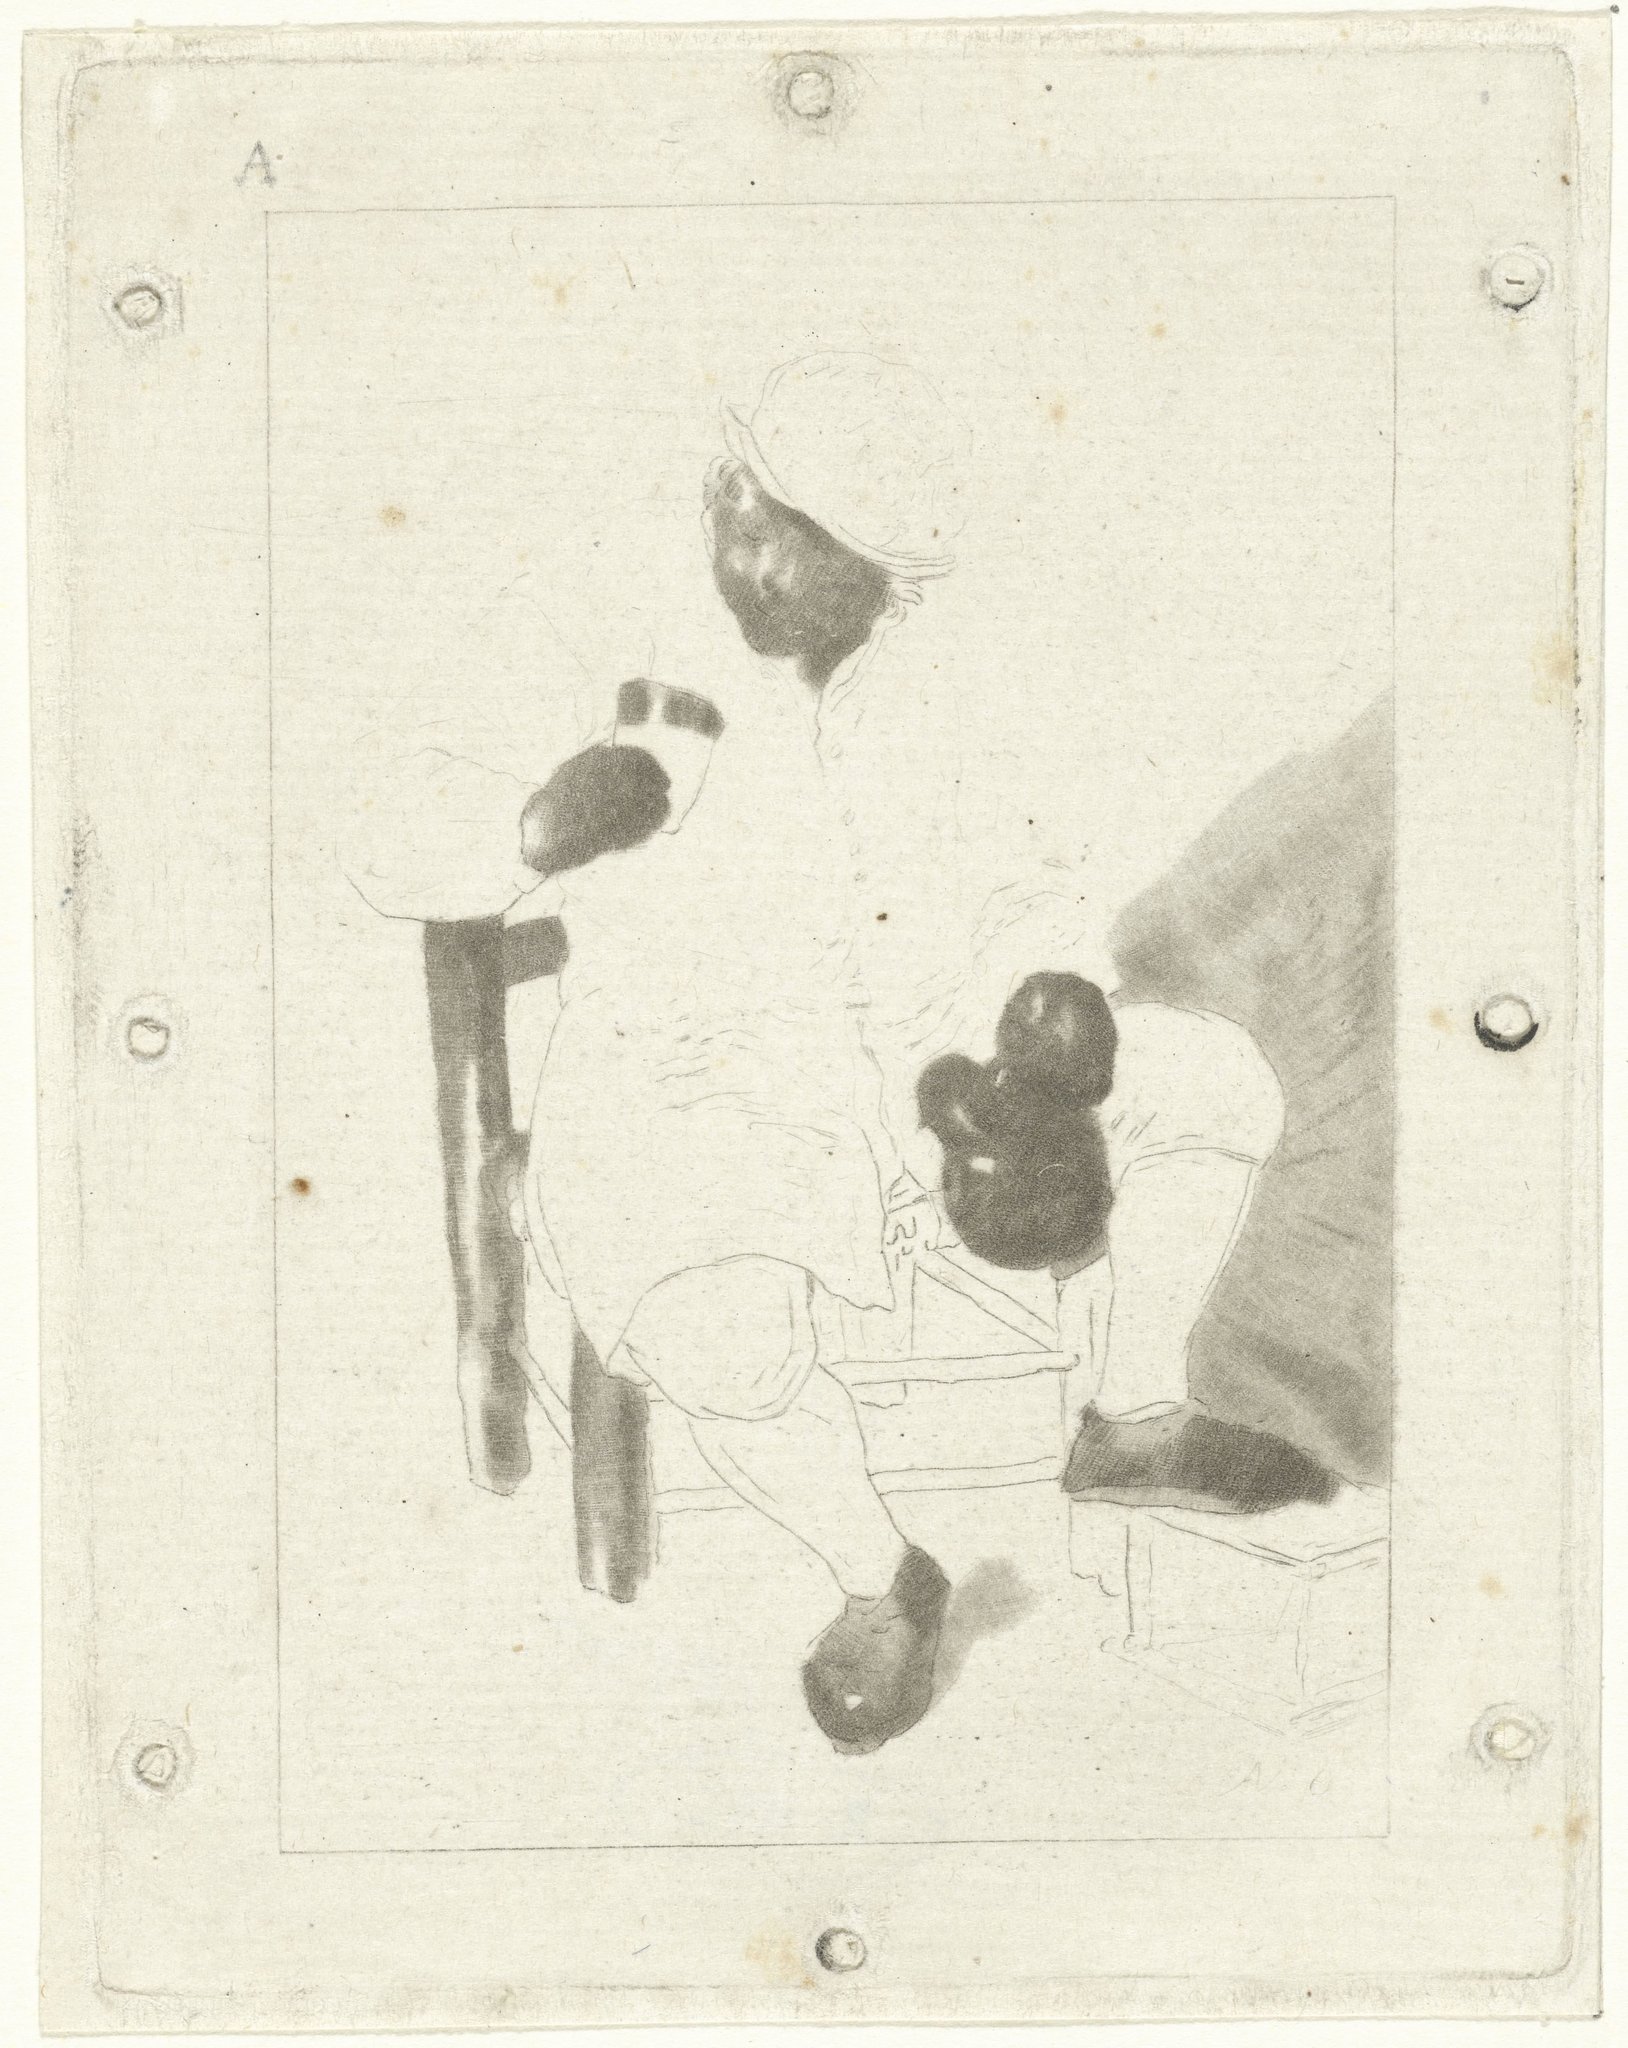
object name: print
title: Zittende boer met kruik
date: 1763-1768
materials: paper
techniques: etching, roulette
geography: amsterdam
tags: sitting figure, jar, jug (used as drinking-vessel)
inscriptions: collector's mark: Lugt 2228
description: Voor deze prenttekening, 'Zittende boer met kruik', maakte Ploos van Amstel vier verschillende platen (A, B, C, en D). Er bestaan afdrukken van één, twee, drie of alle vier de platen in alle mogelijke combinaties. Zie gerelateerde objecten voor de hier gebruikte plaat.